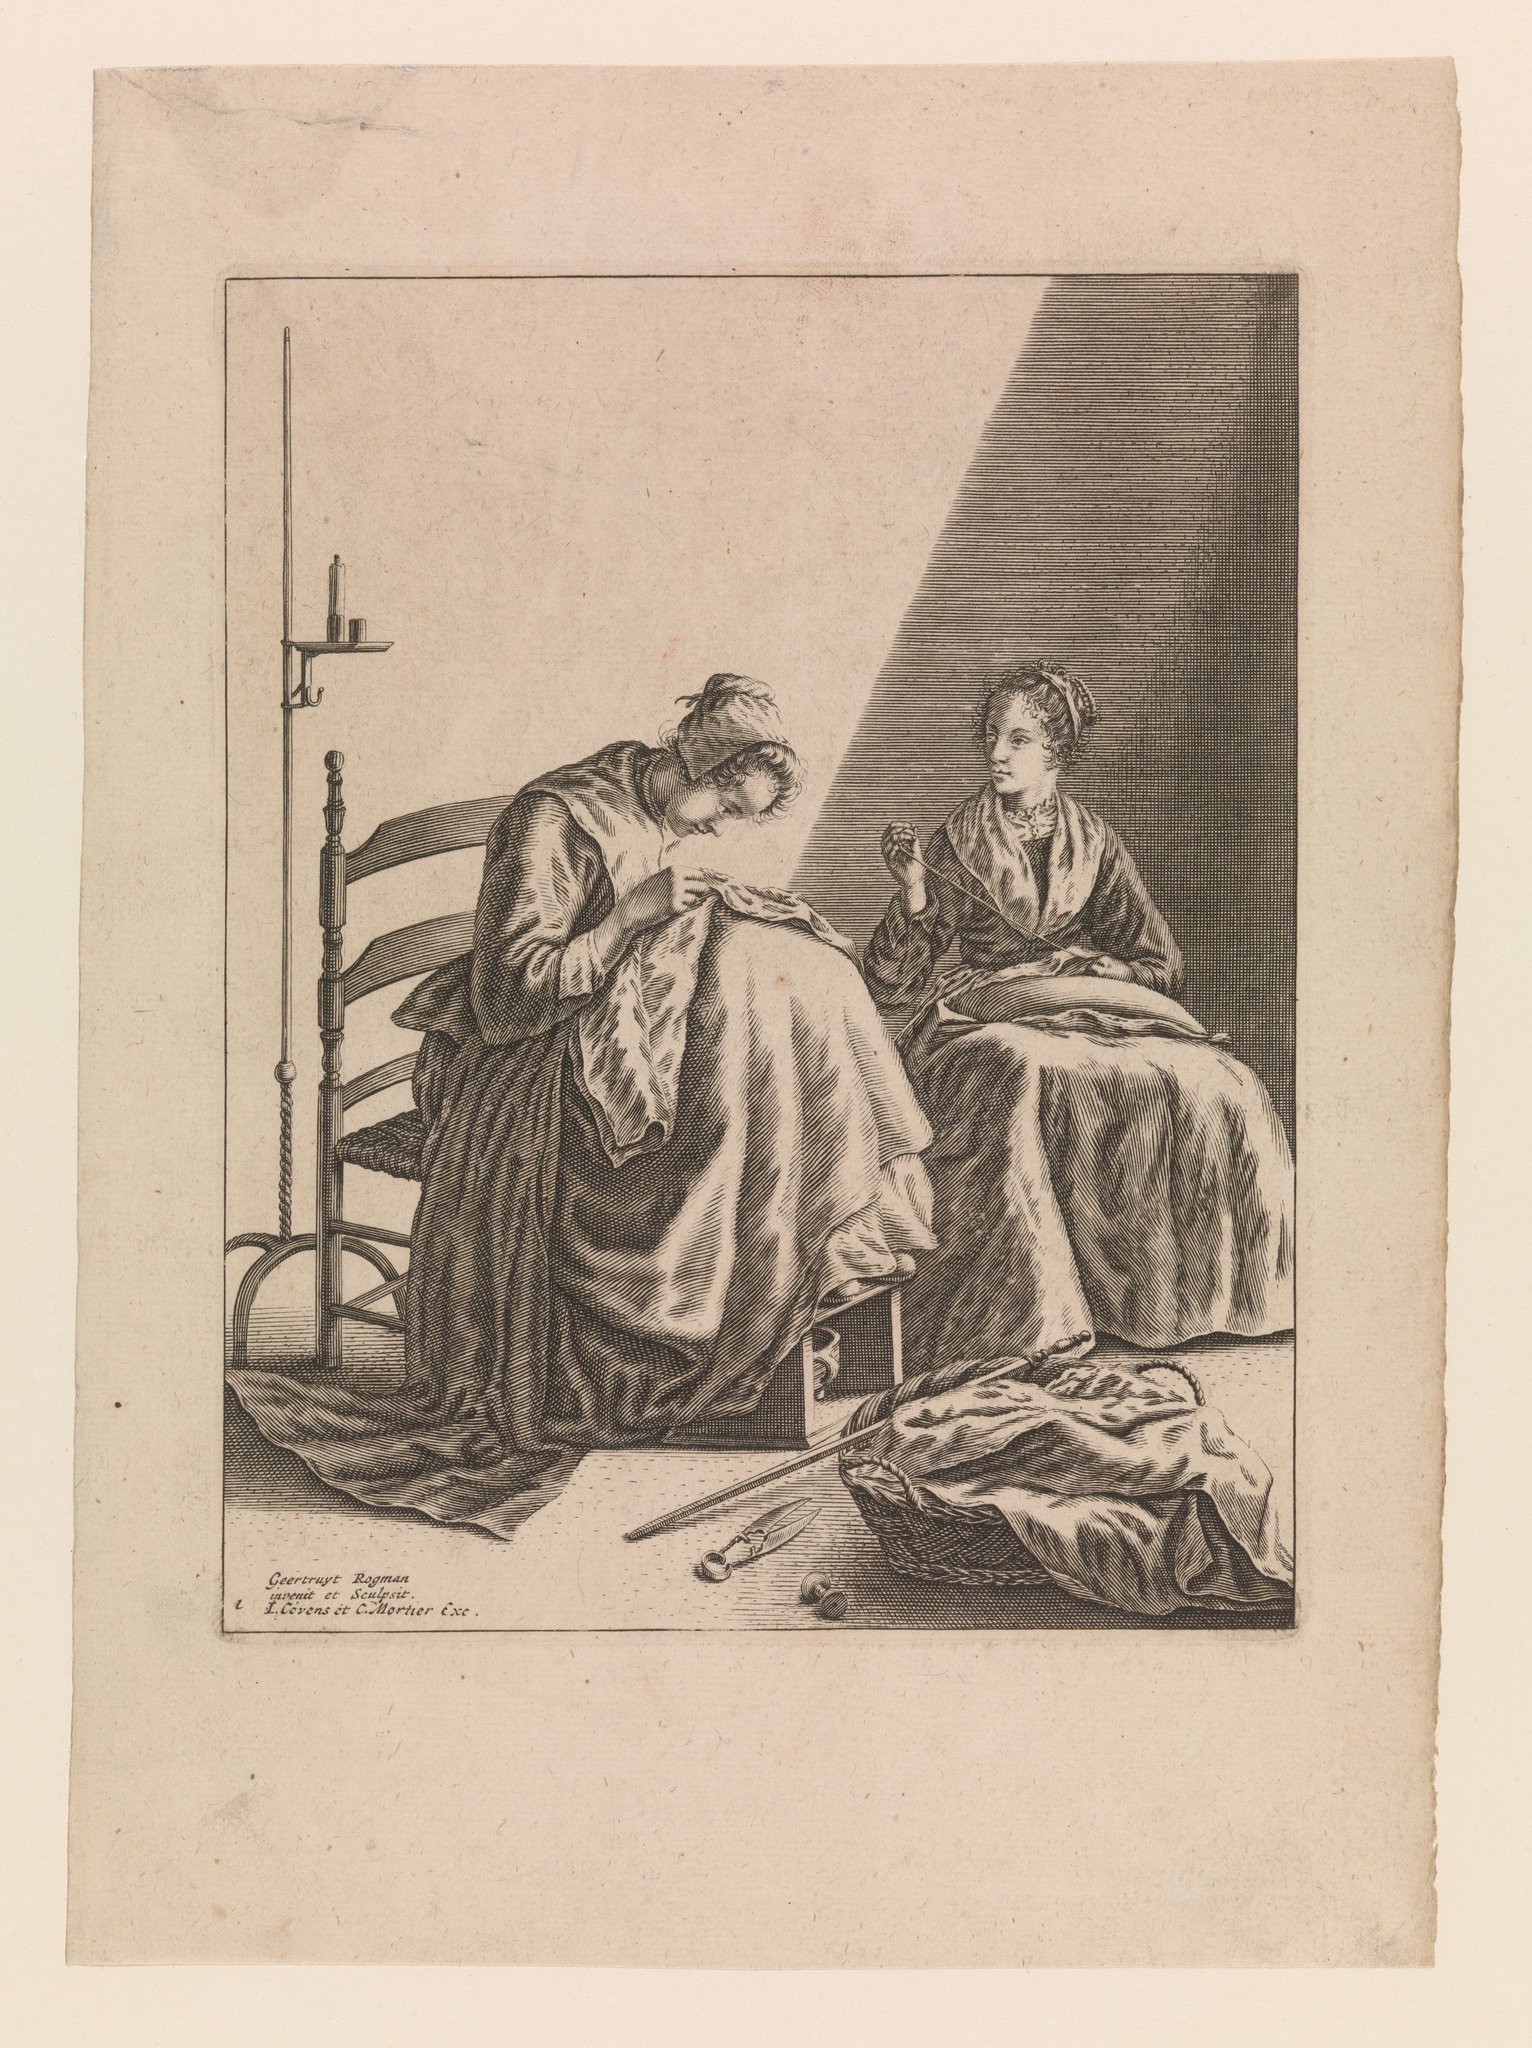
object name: print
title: Two Women Sewing, Plate 1 from "Five Feminine Occupations"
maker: geertruydt roghman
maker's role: artist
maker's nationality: dutch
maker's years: 1625-1657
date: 1640-1657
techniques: engraving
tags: women,working,sewing